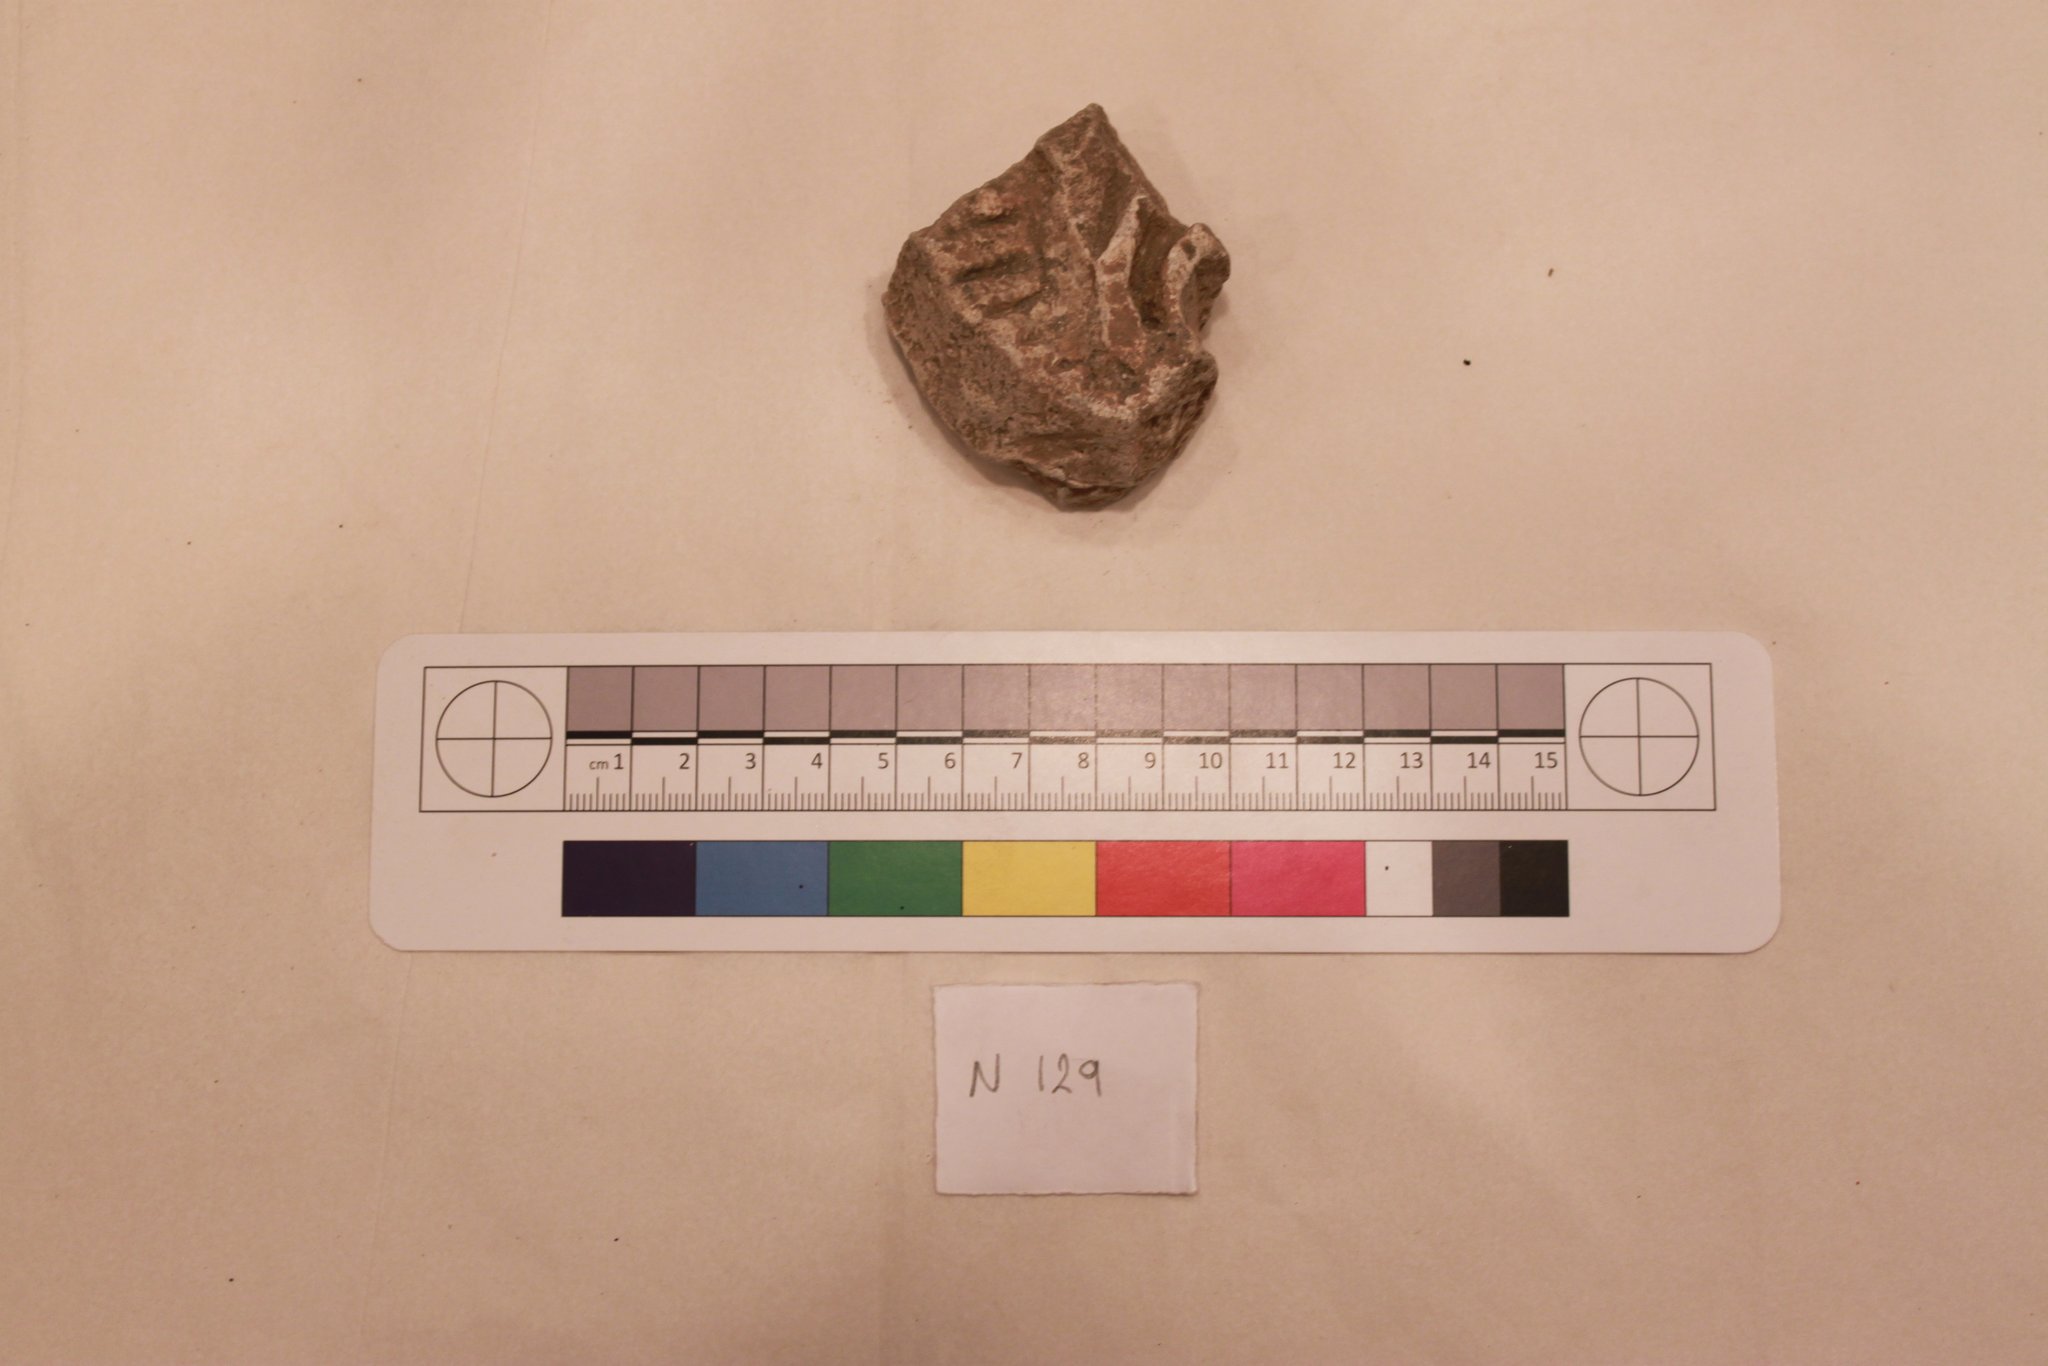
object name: fragment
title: Stucco Fragment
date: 701-1200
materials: plaster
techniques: carving, painting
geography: iran